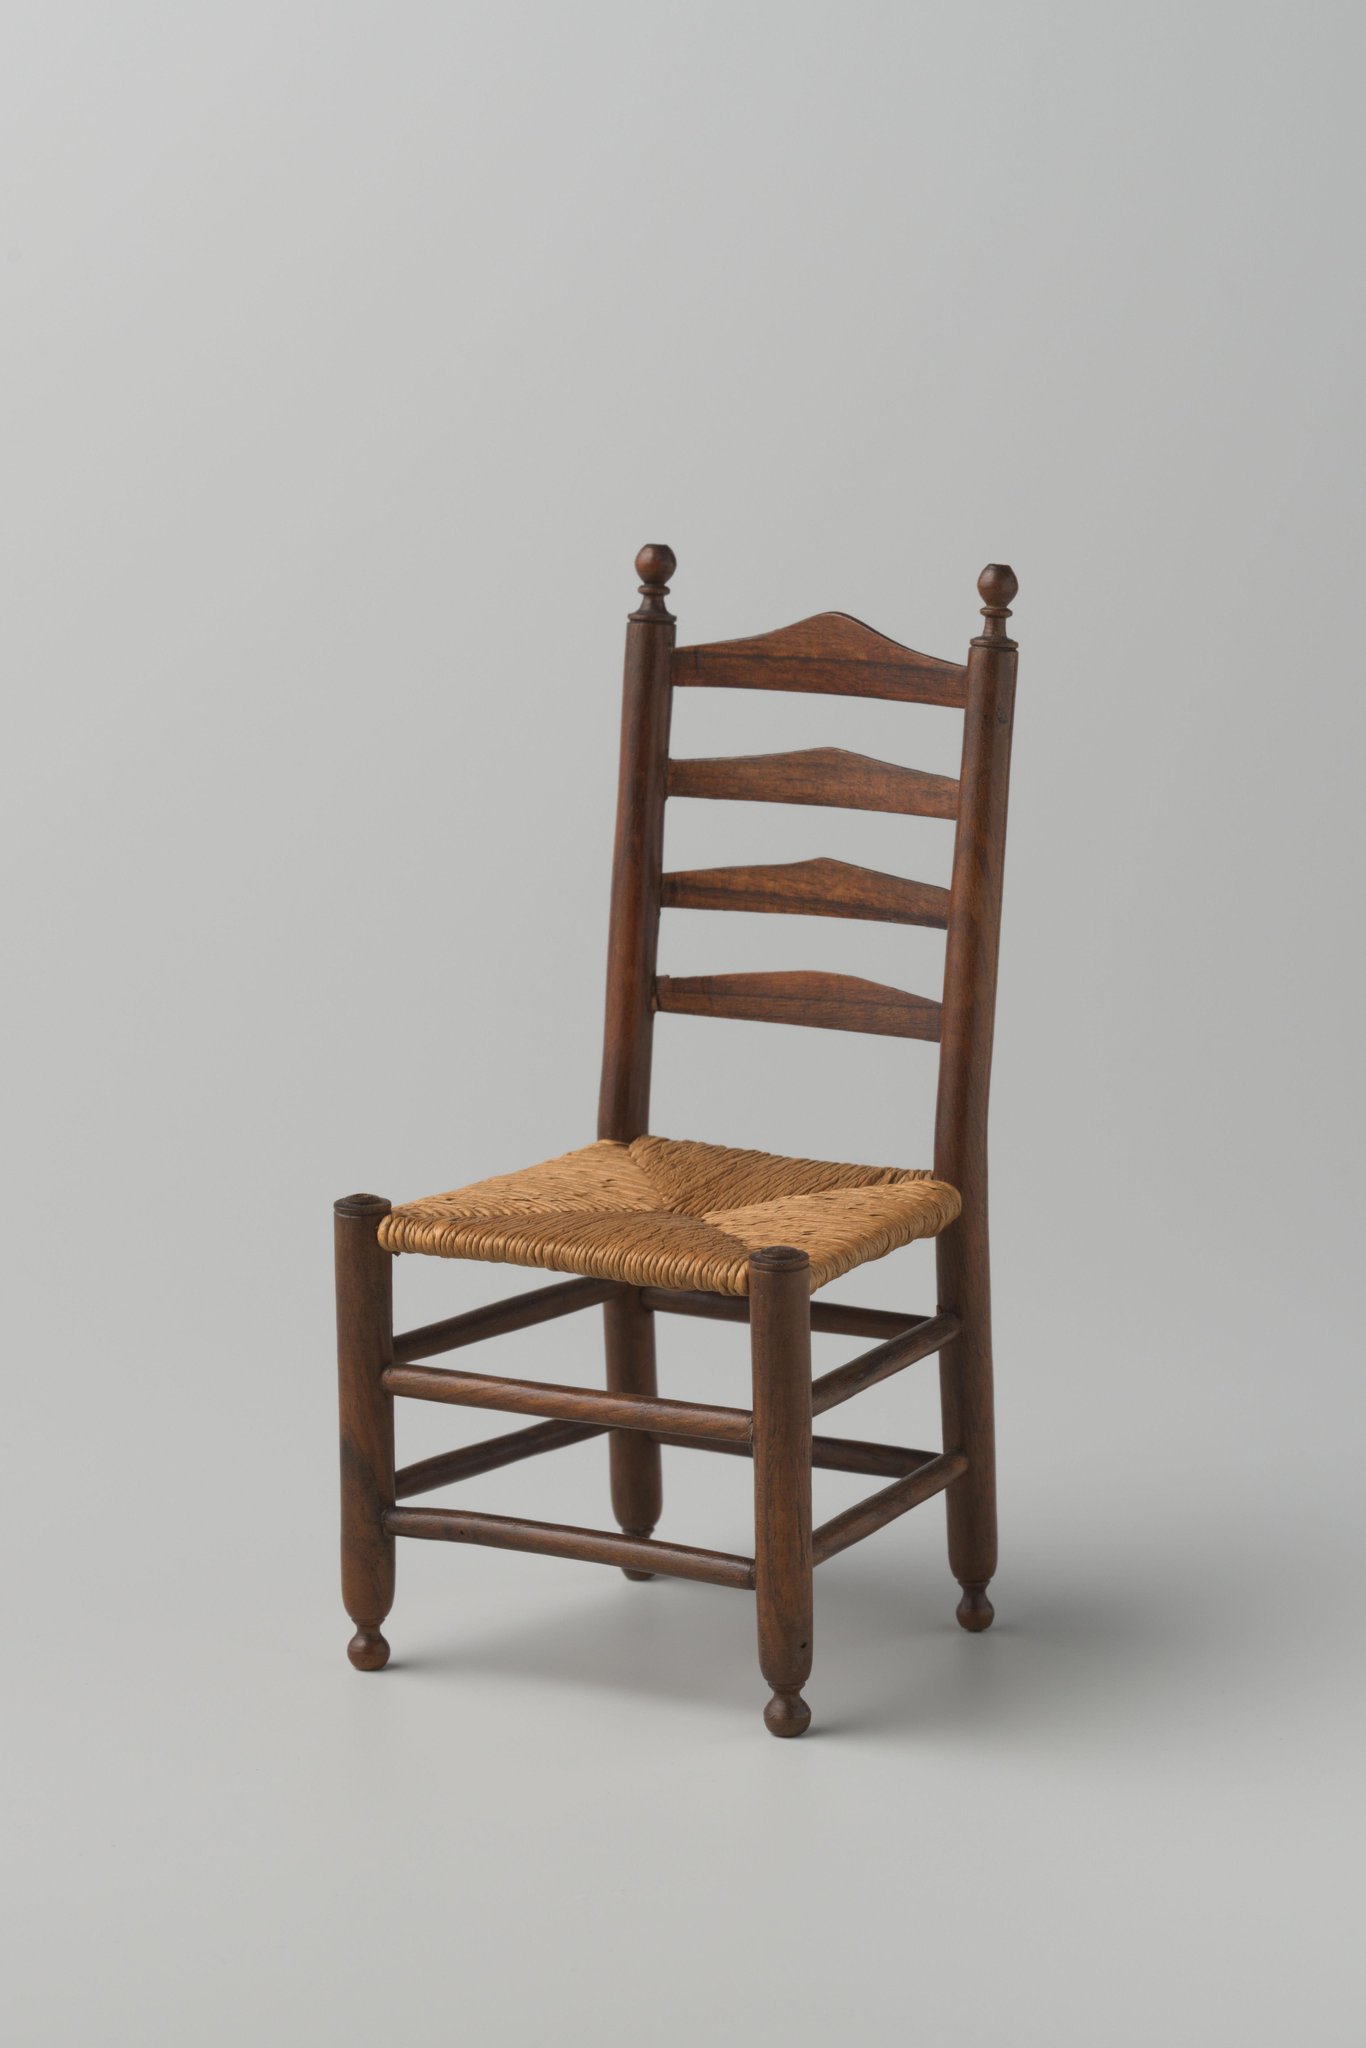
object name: chair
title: Knopstoel met matten zitting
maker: Anonymous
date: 1690-1710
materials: fiber, wood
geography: amsterdam